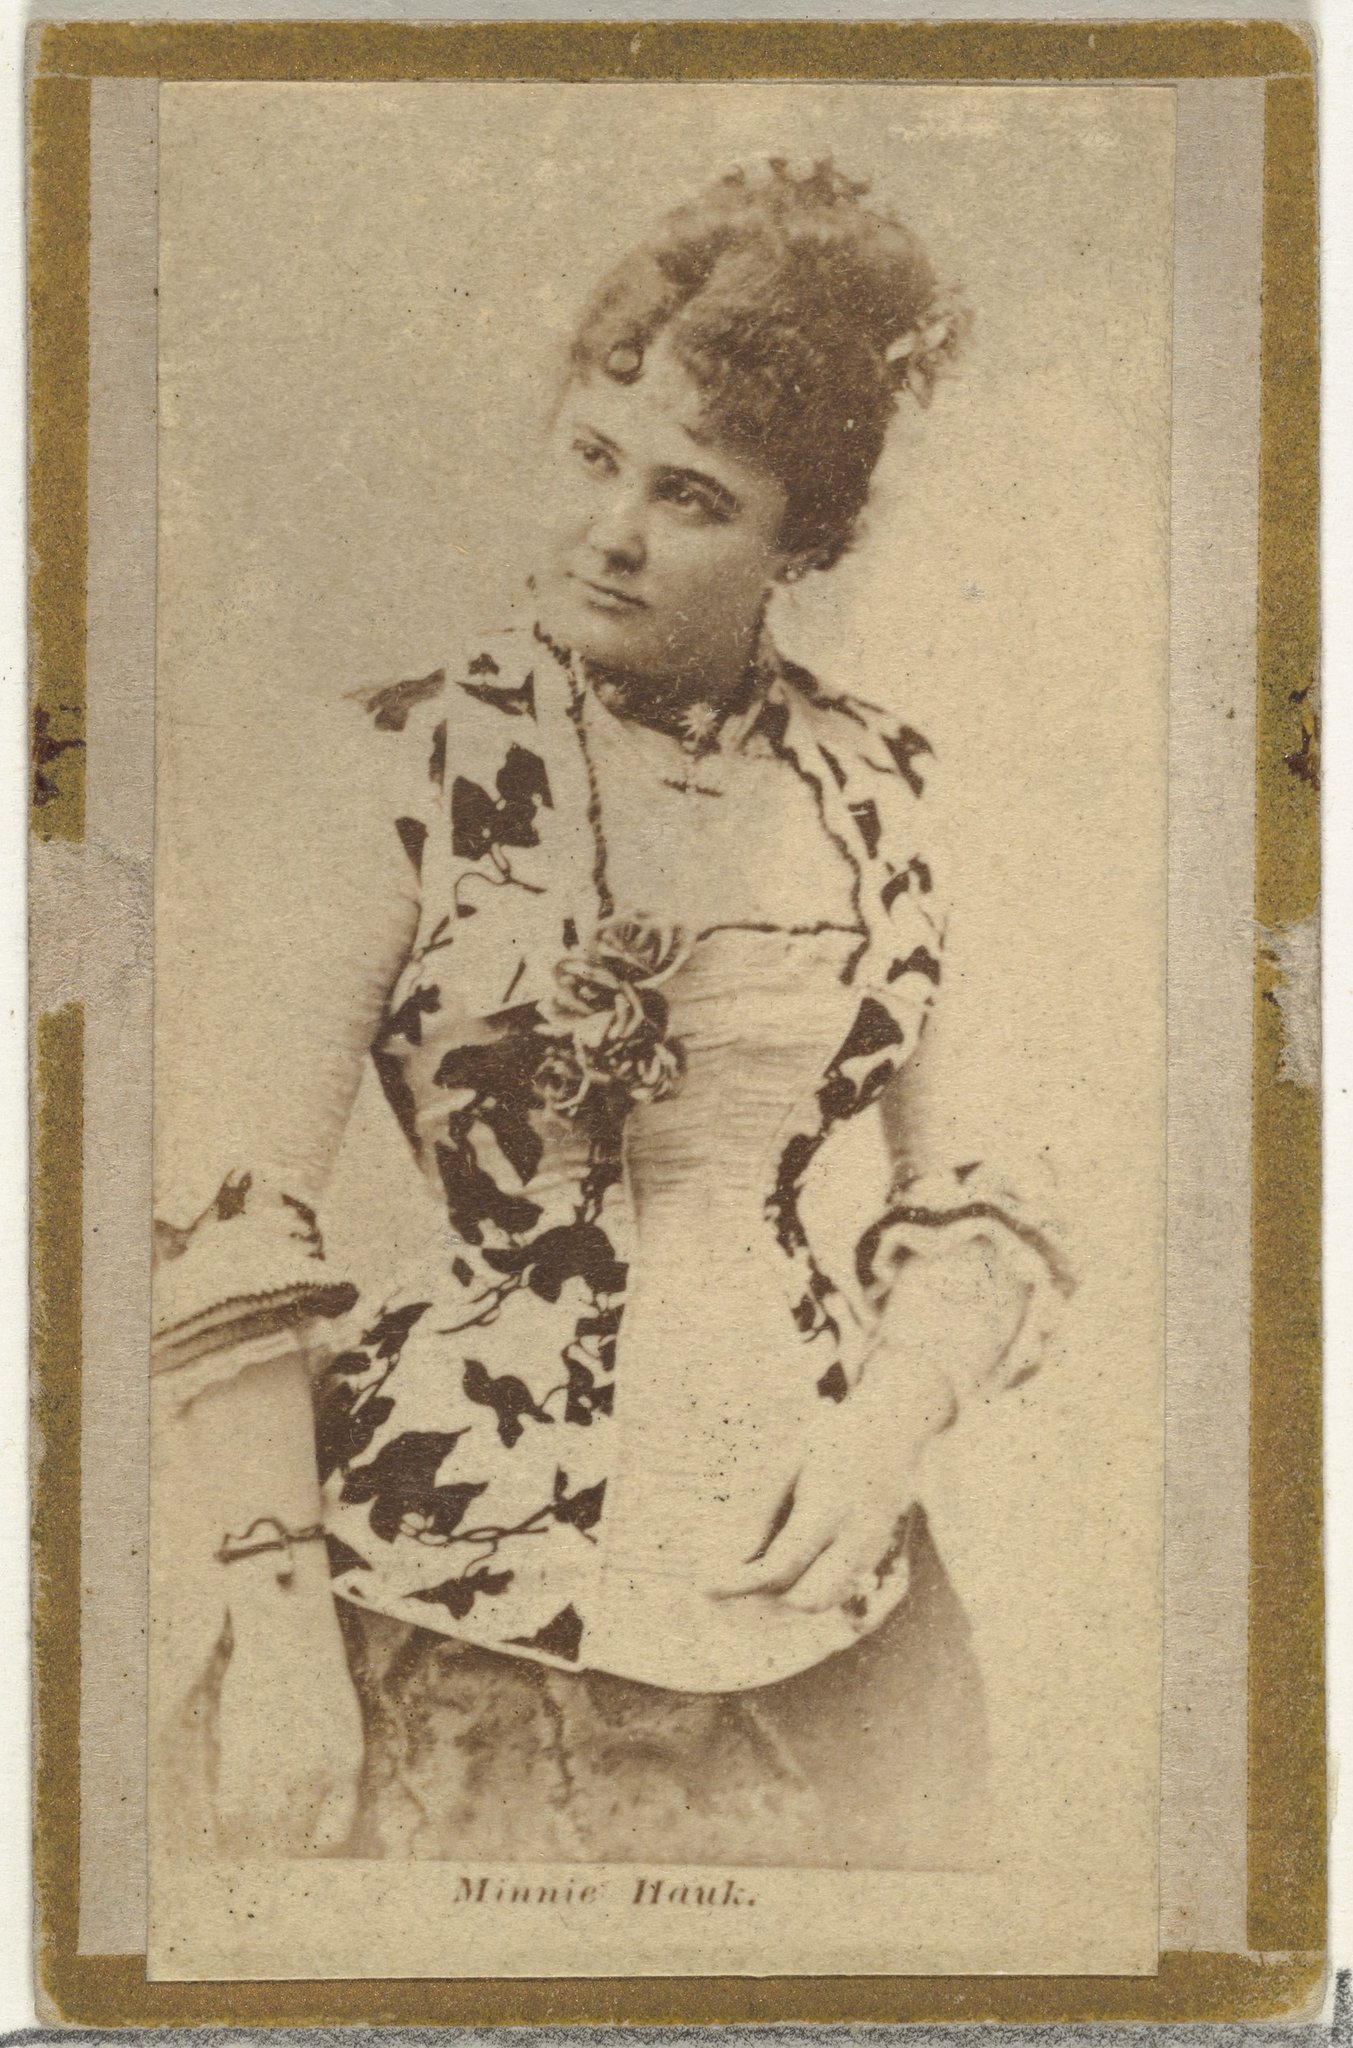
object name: photograph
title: Minnie Hauk, from the Actresses and Celebrities series (N60, Type 2) promoting Little Beauties Cigarettes for Allen & Ginter brand tobacco products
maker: allen & ginter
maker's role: publisher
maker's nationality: american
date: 1887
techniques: albumen silver print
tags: portraits,women,actresses